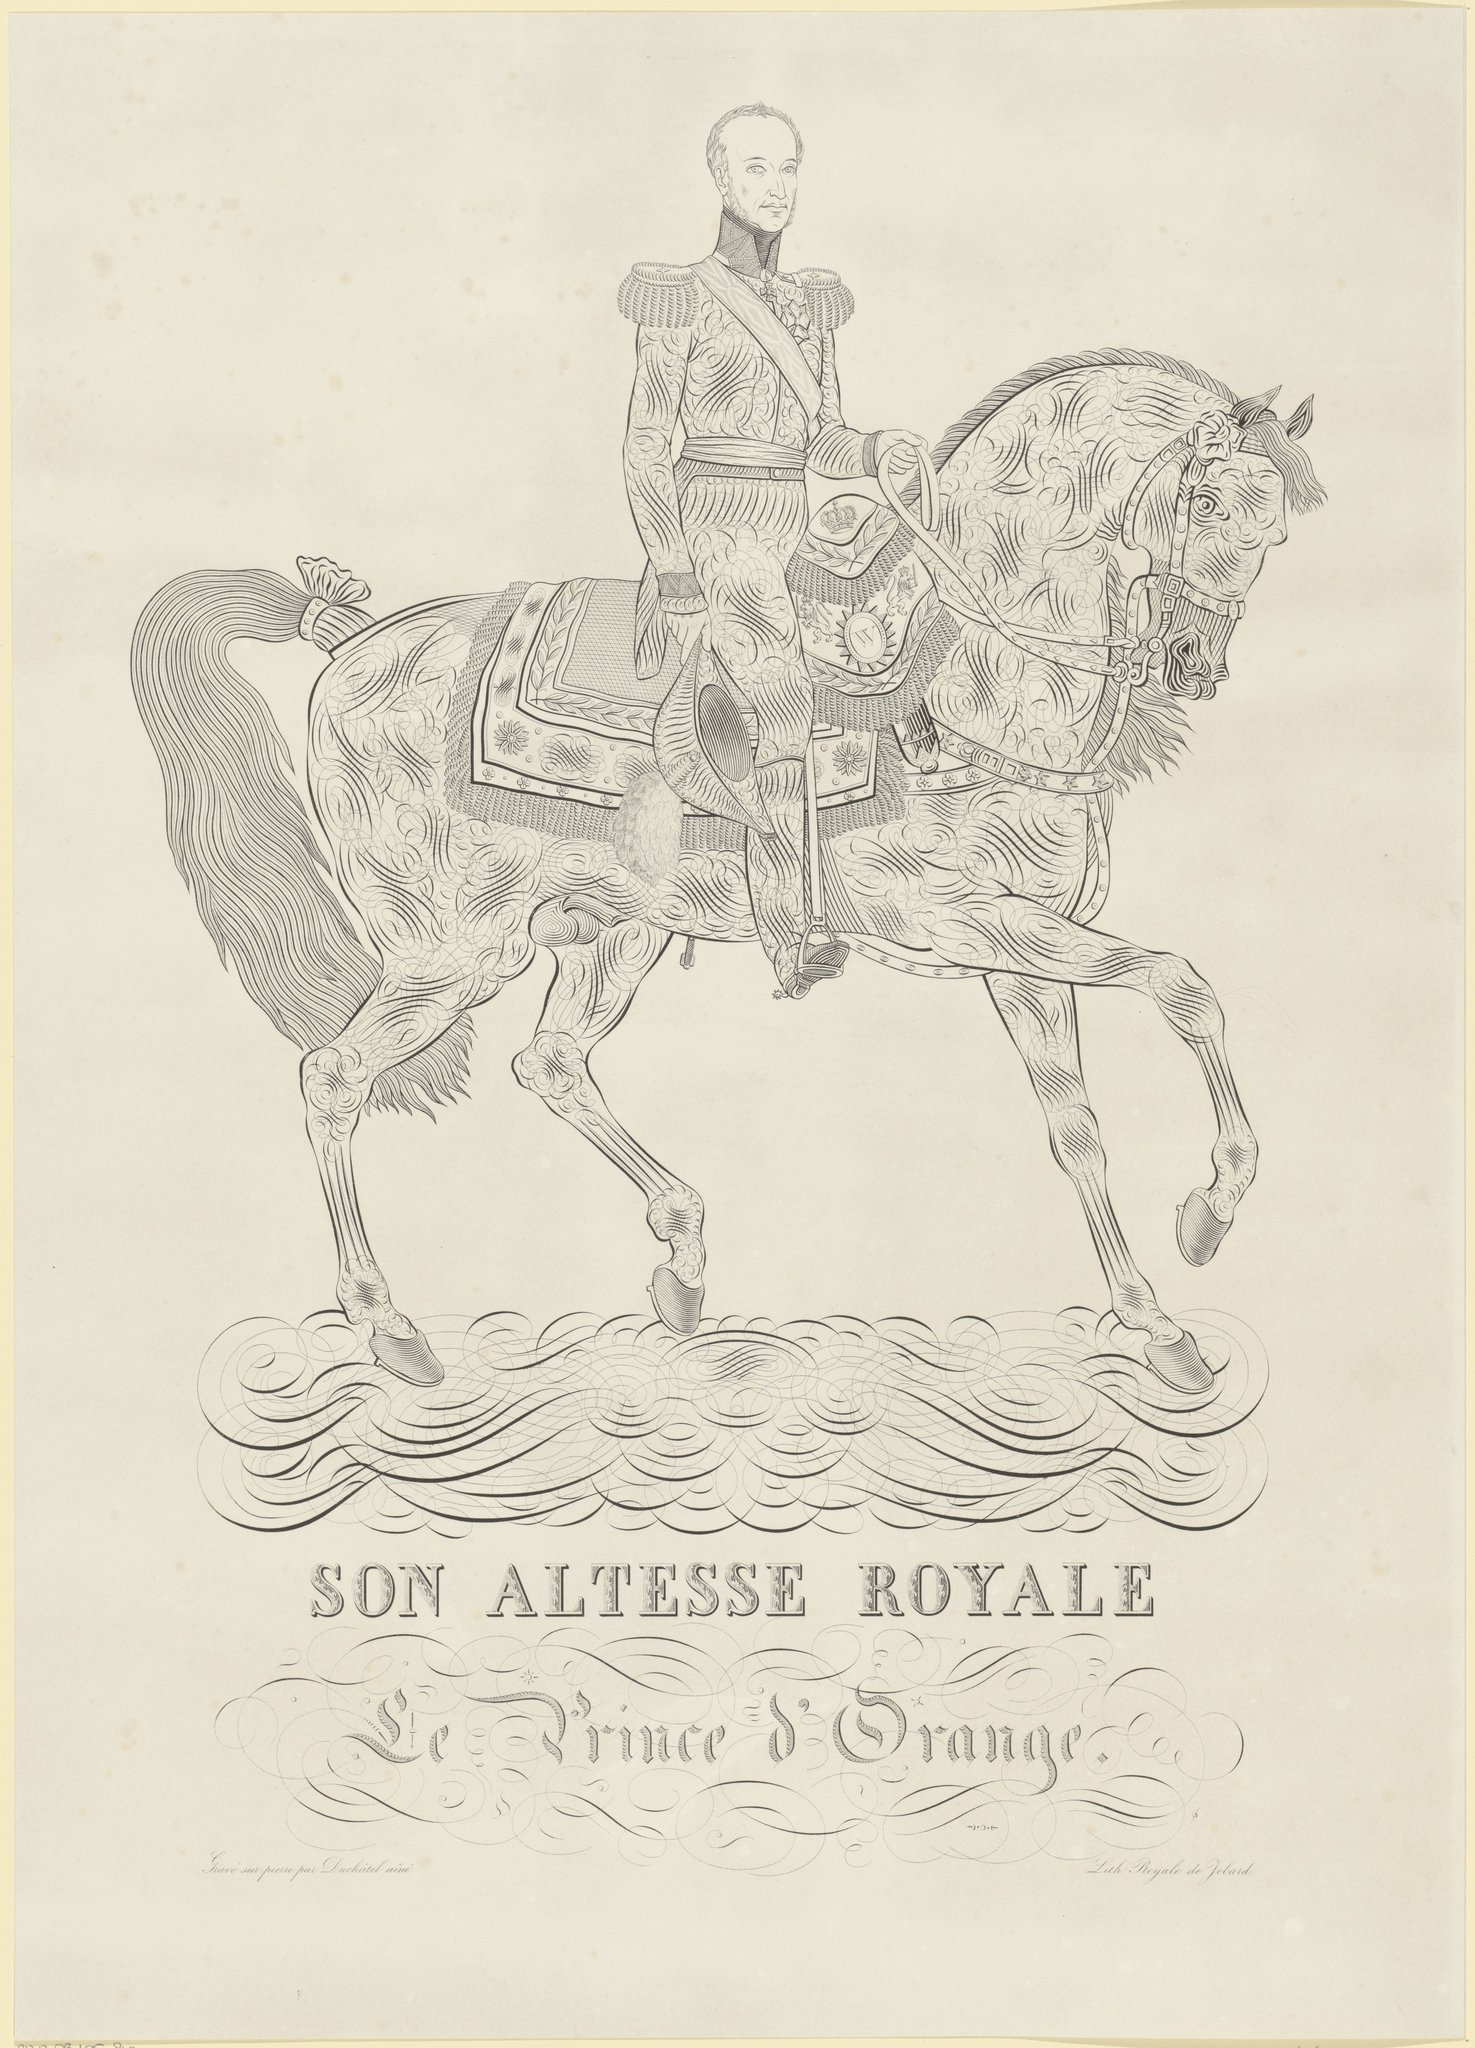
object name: print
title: Ruiterportret van Willem II, koning der Nederlanden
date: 1815-1861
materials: paper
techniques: lithograph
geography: brussels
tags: the hague, william ii of the netherlands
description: De hier vermelde titel verwijst naar de hoogst verkregen titel van de geportretteerde, niet per se naar de titel die de geportretteerde op deze voorstelling draagt.